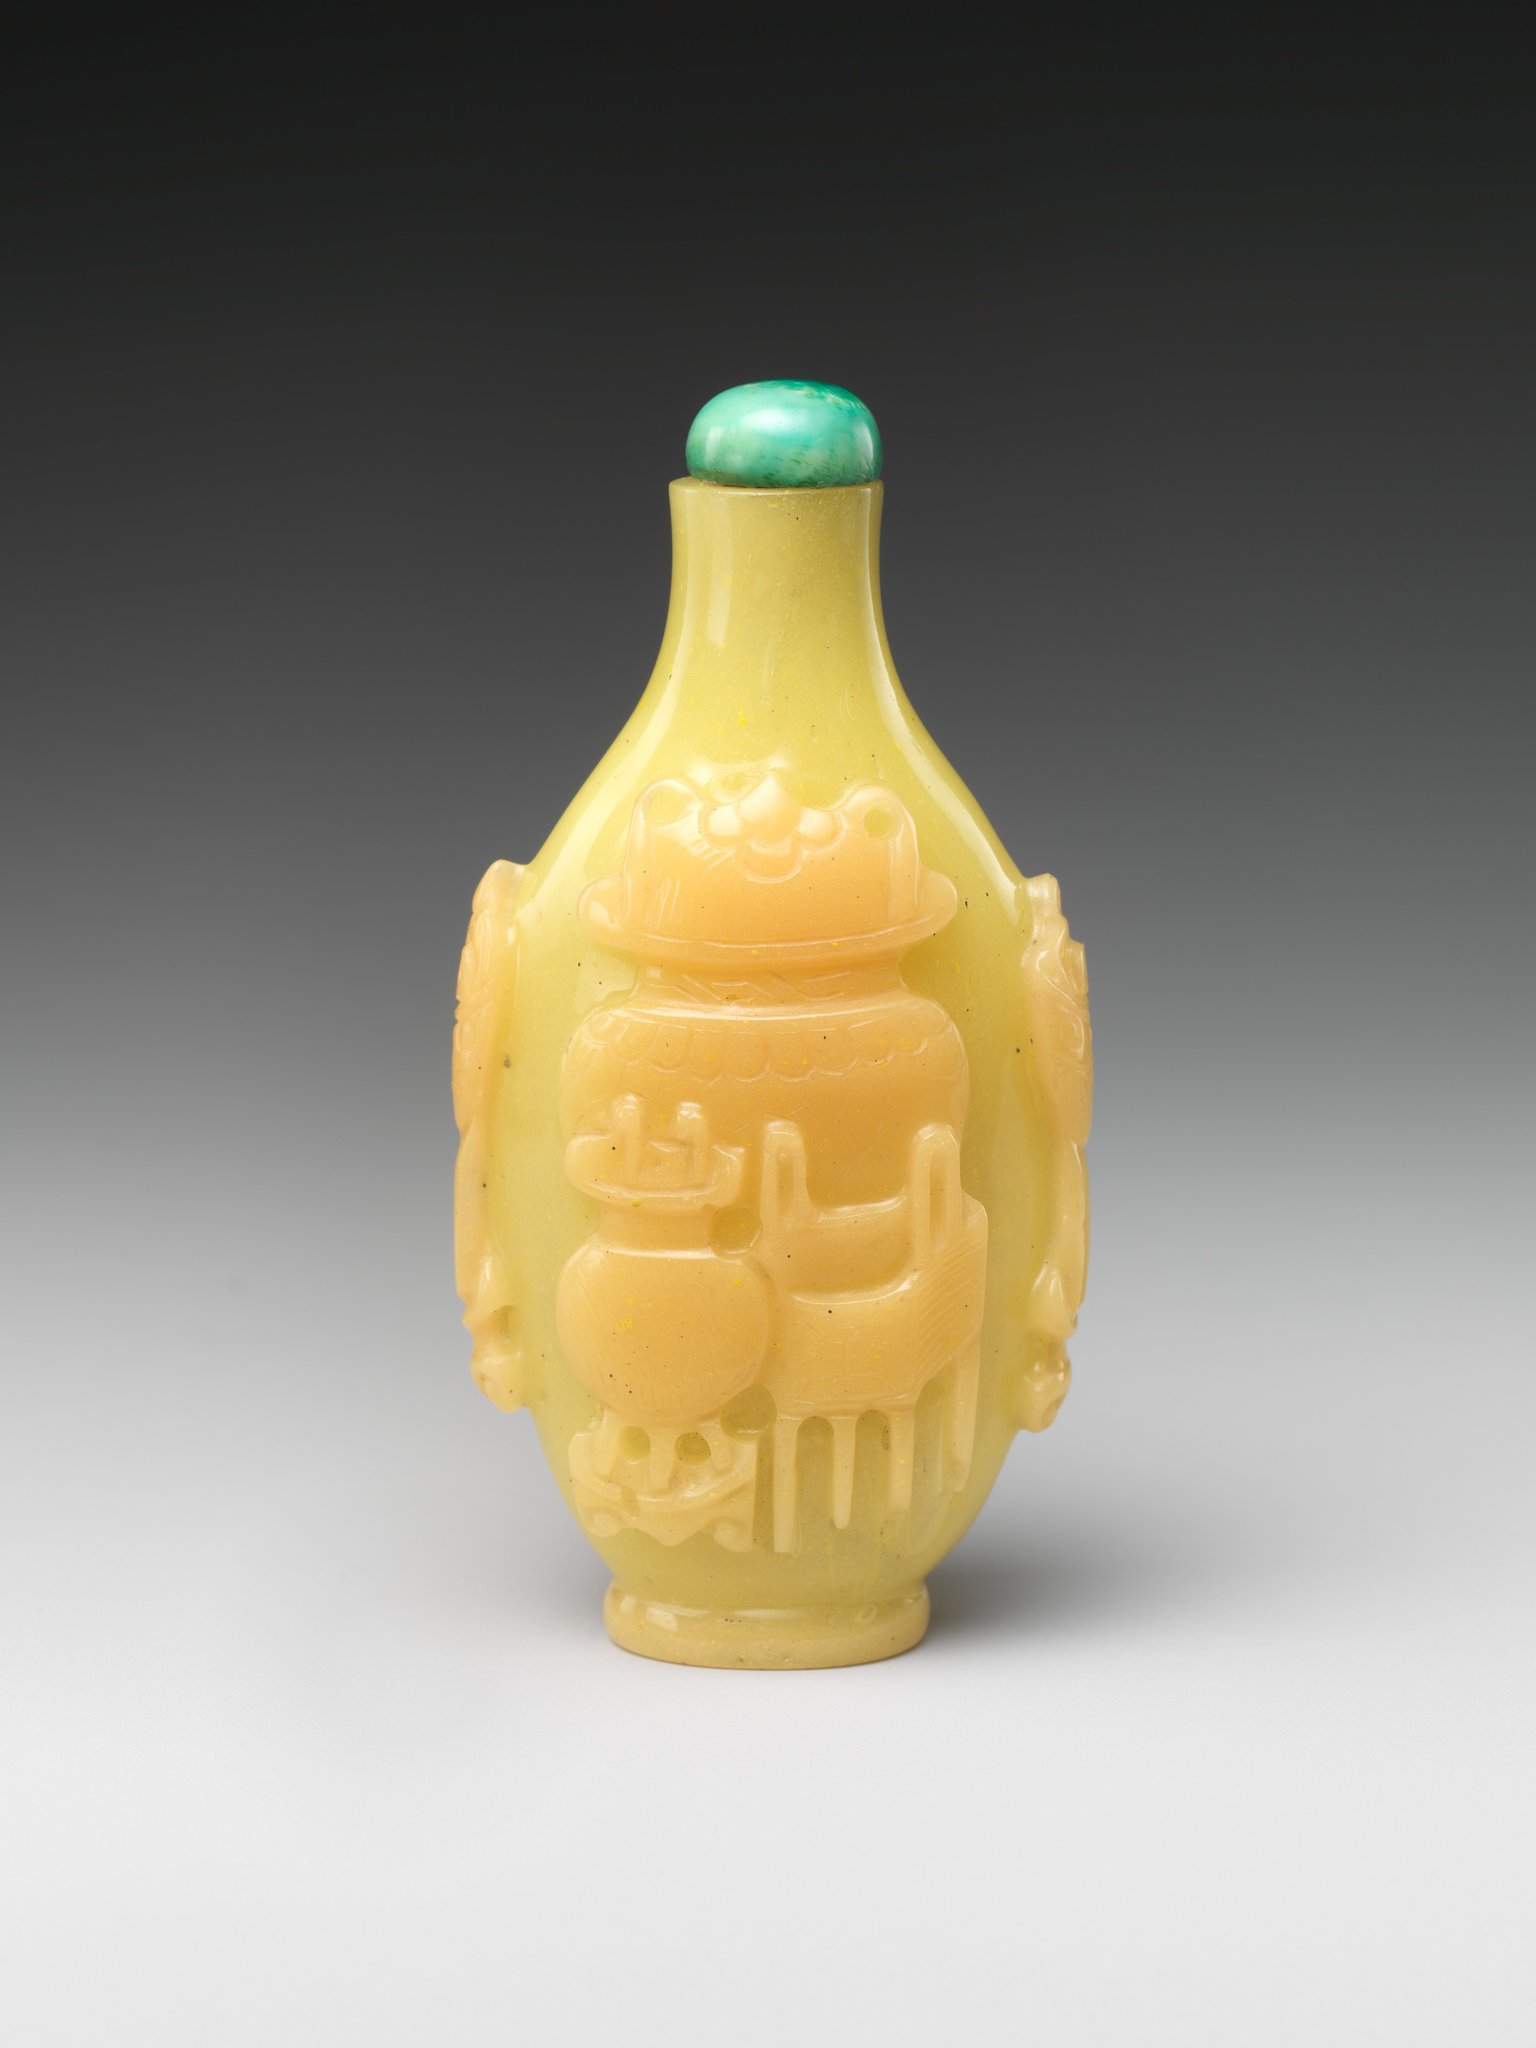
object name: snuff bottle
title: Snuff Bottle with Antique Vessels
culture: chinese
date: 1767-1833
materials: glass